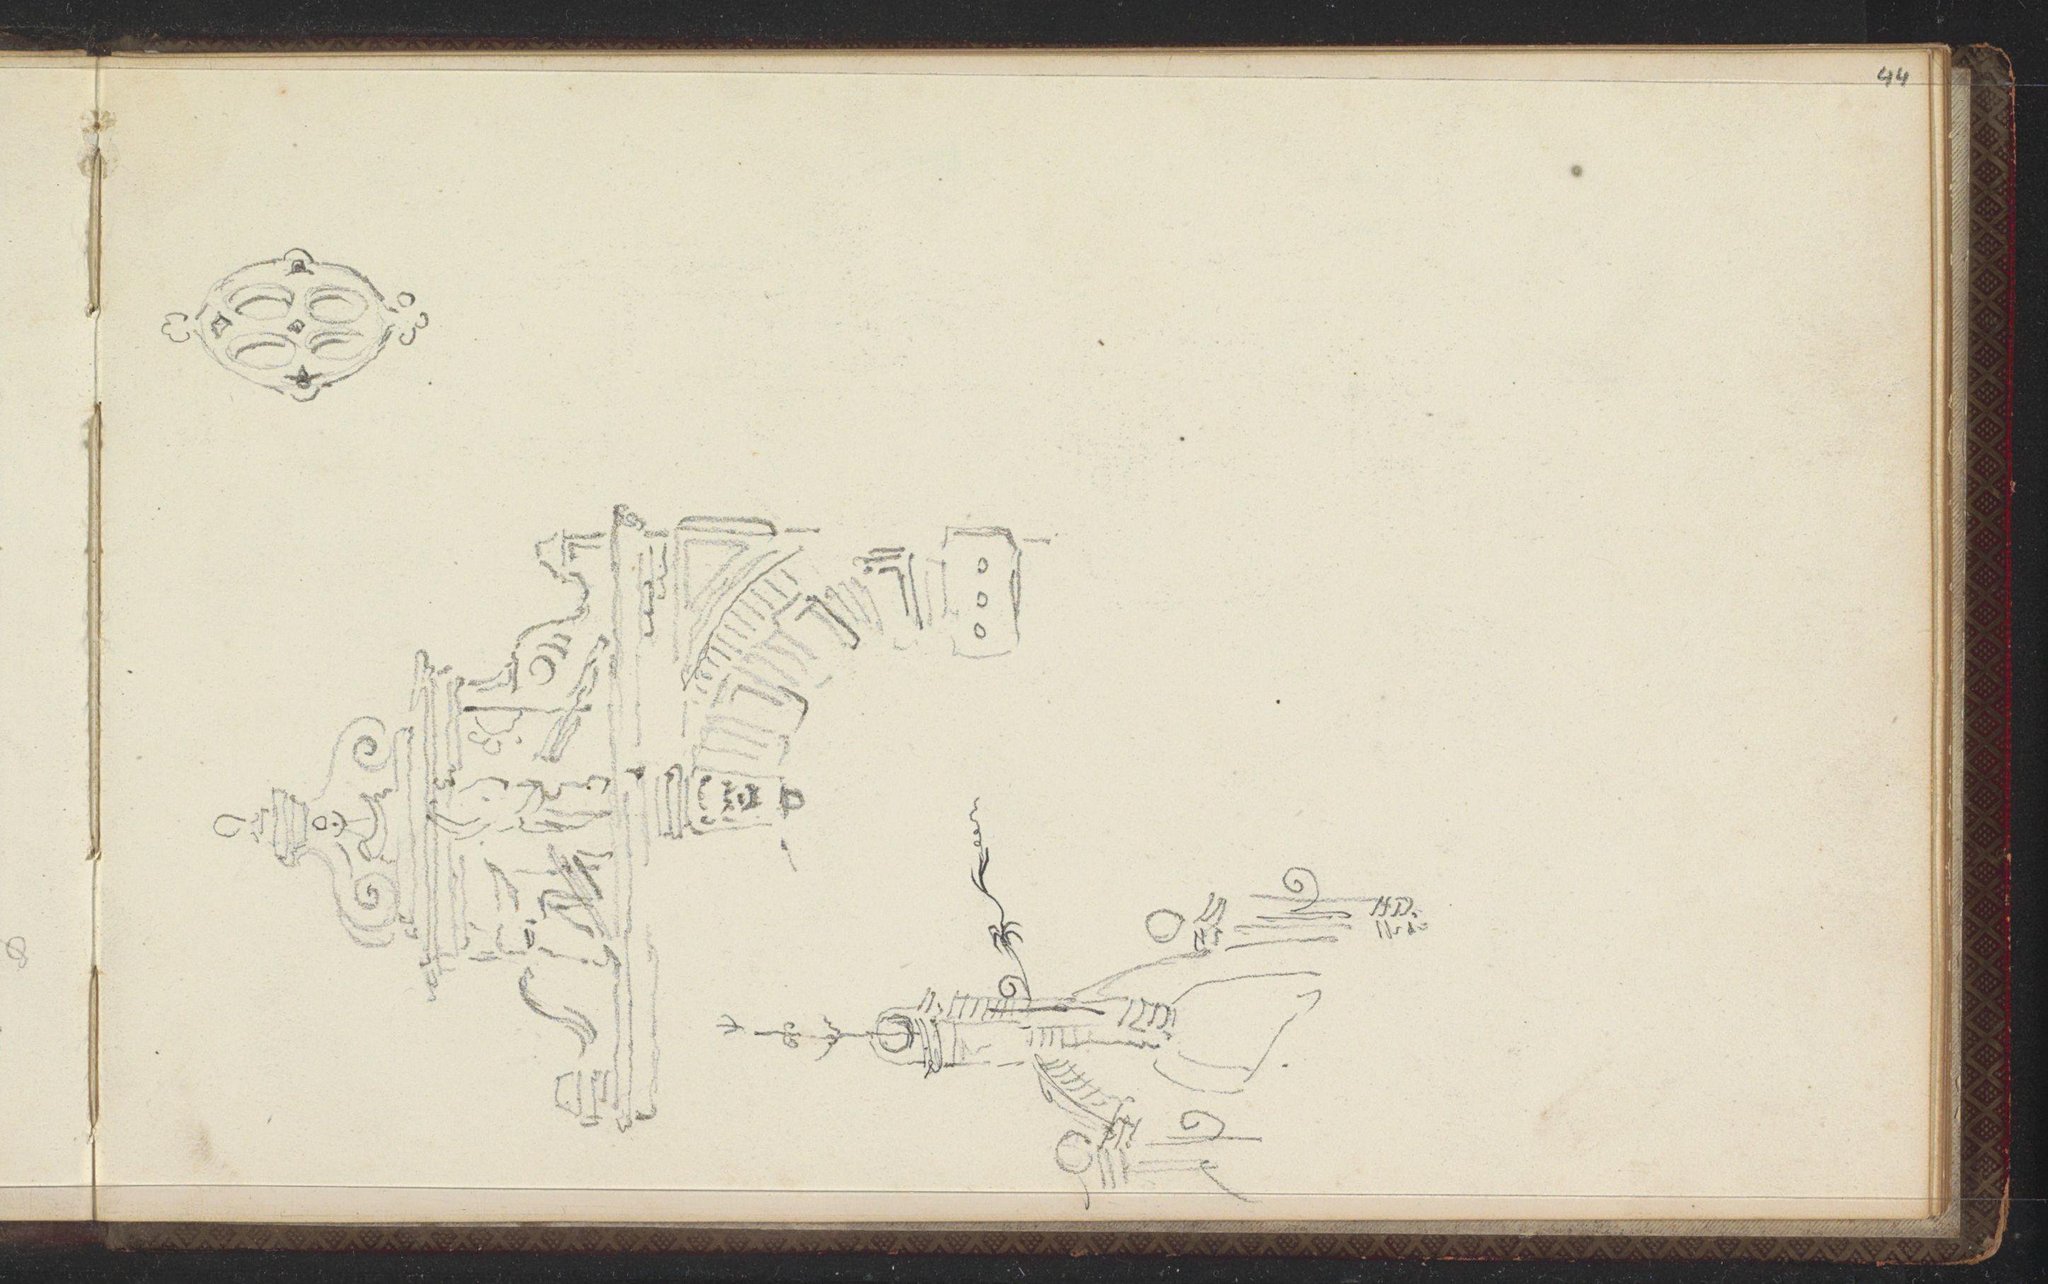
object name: sketchbook leaf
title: Architectuurstudies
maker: adrianus eversen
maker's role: draughtsman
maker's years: 1818-1897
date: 1828-1897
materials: paper, pencil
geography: netherlands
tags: arch, archivolt ~ architecture, architecture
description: Linksboven een studie van een rondboog, mogelijk van een poort. Links en rechts studies van architectonische details. Blad 44 recto uit een schetsboek met 52 bladen vervaardigd in de omgeving van Kampen, Hattem, Hoorn en Zwolle.